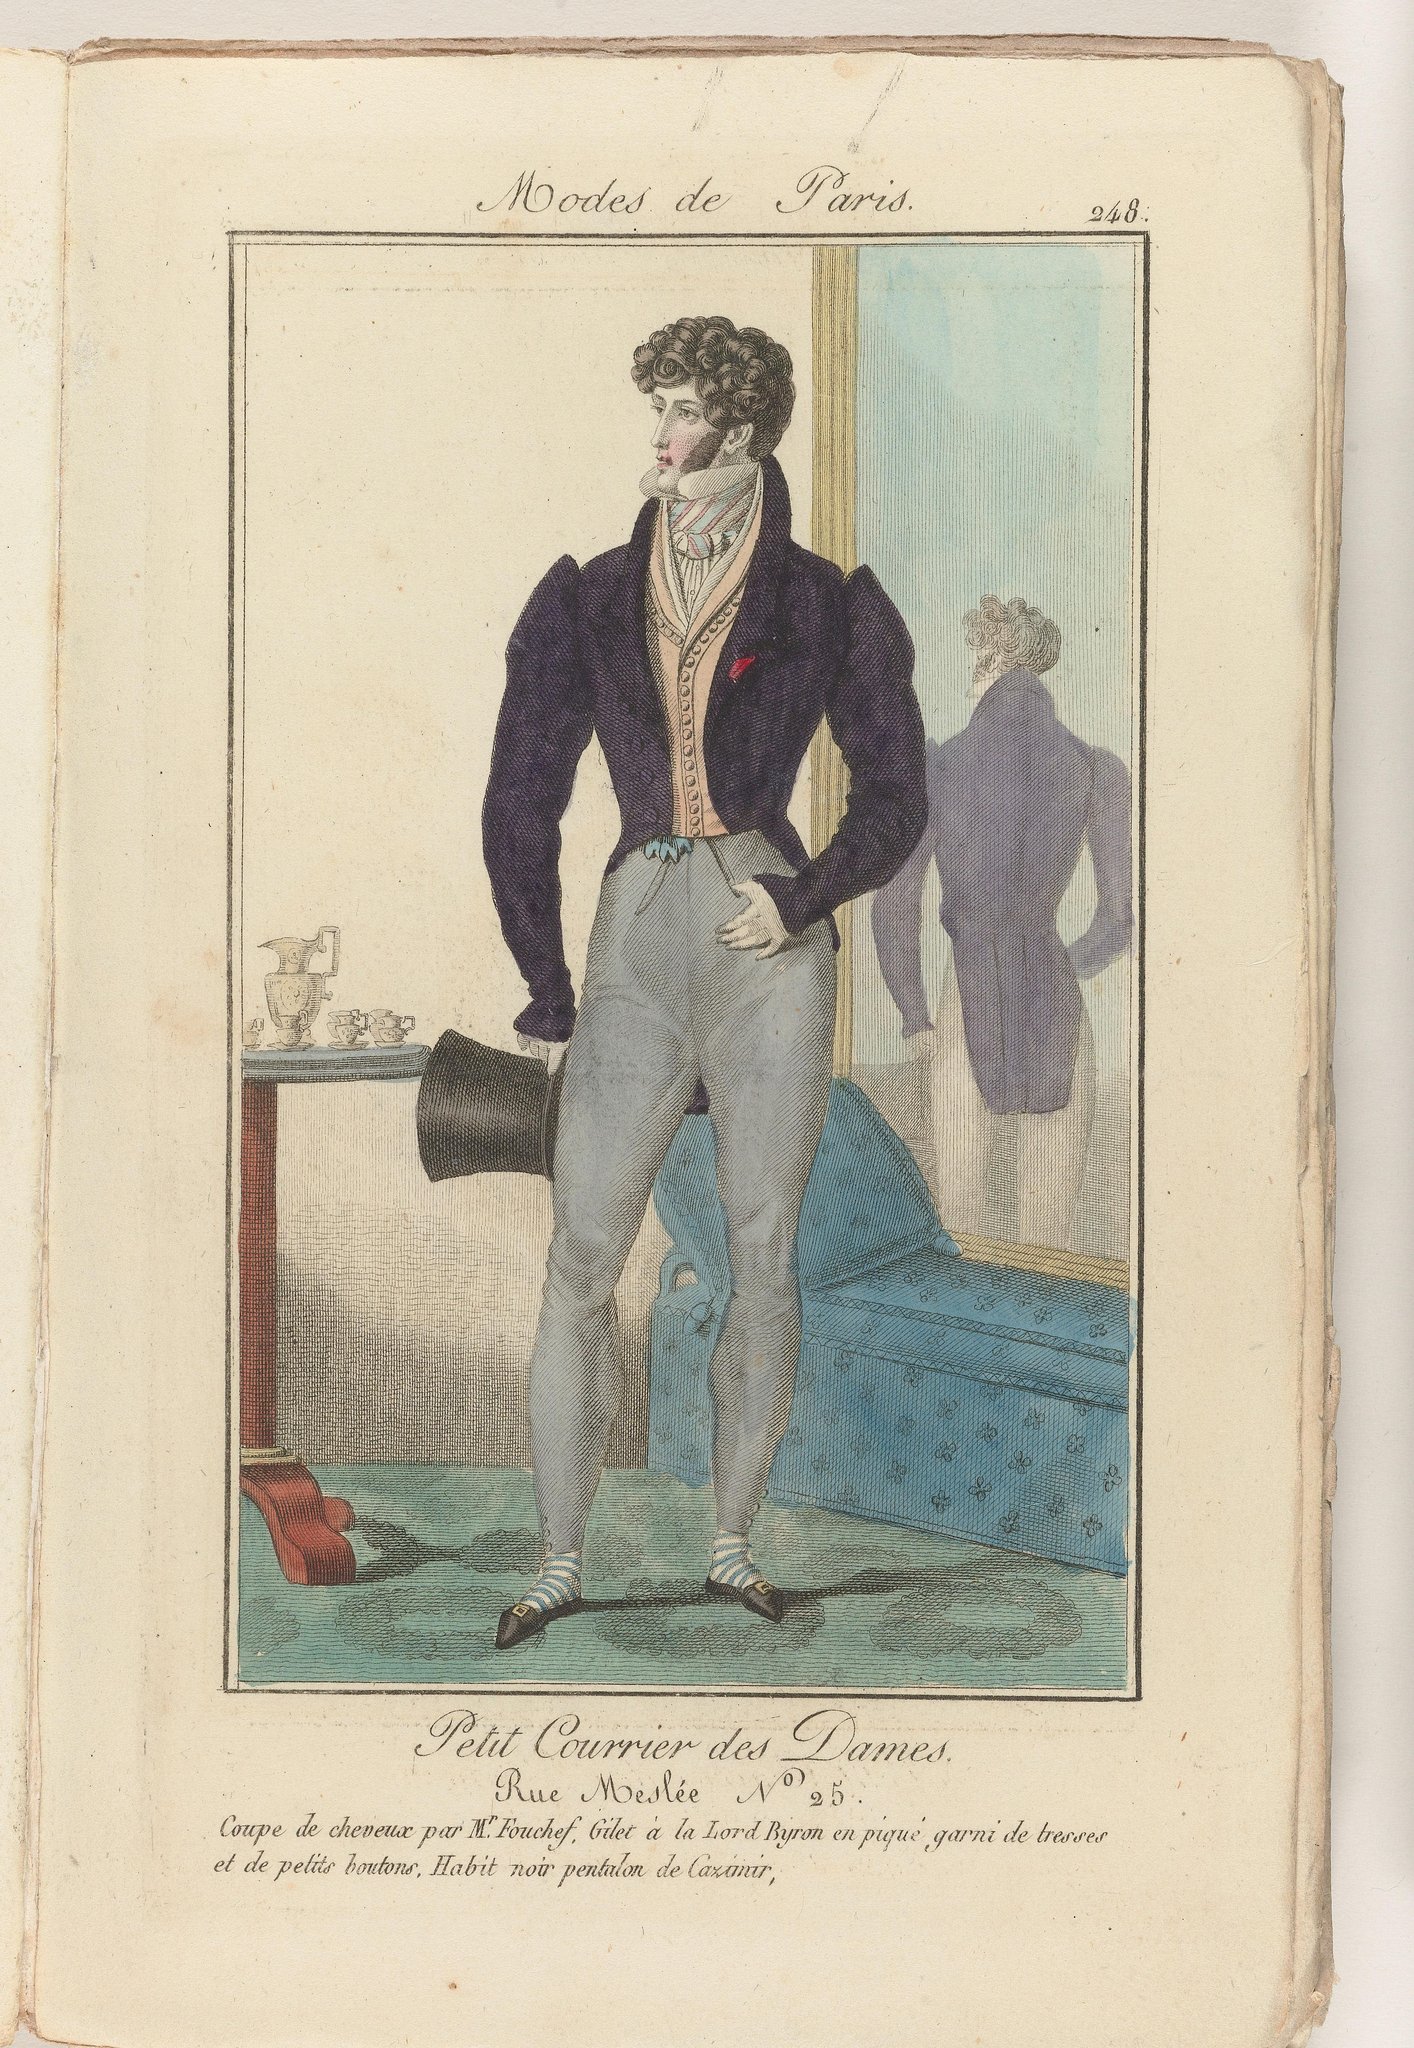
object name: fashion print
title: Petit Courrier des Dames 1824 (248)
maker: Anonymous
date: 1824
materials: paper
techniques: engraving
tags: fashion plates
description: Prent uit het modetijdschrift Petit Courrier des Dames (1821-1868).